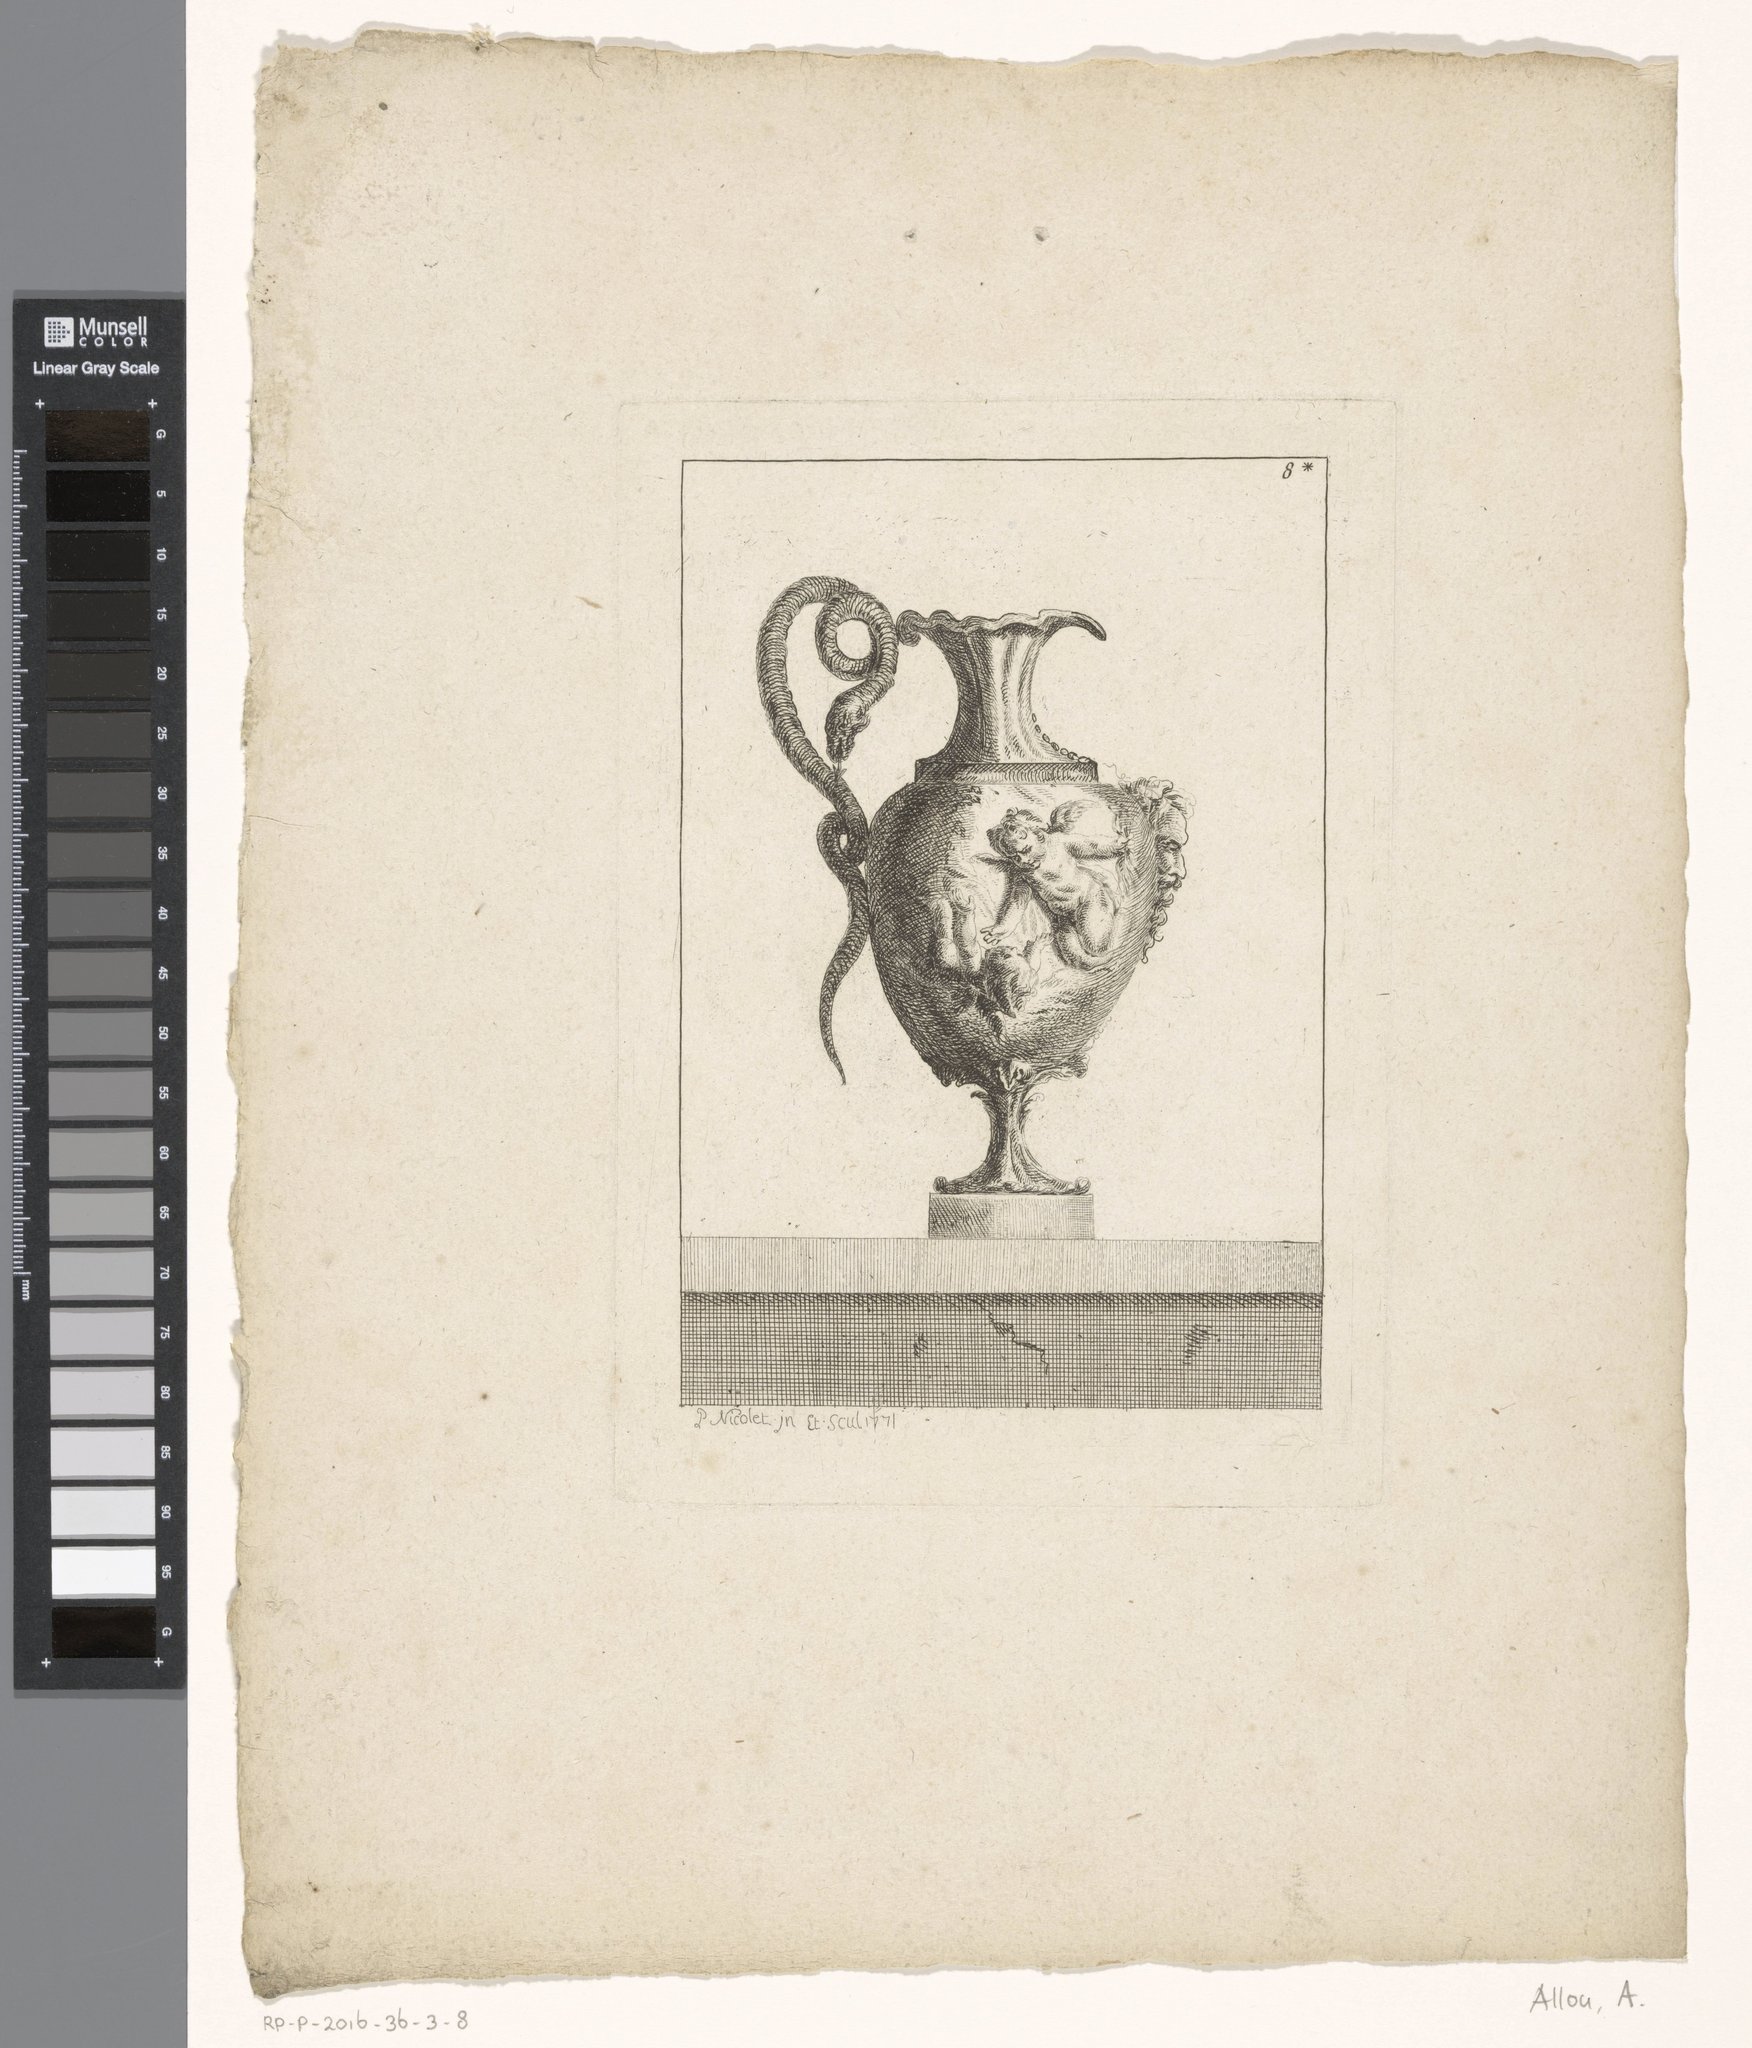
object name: print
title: Vaas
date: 1771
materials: paper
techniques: etching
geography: paris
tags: vase ~ ornament, garden vase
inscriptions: collector's mark: Lugt 2228, collector's mark: Lugt 2760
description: Prent uit een genummerde serie met twaalf vazen door Allou en Nicolet.